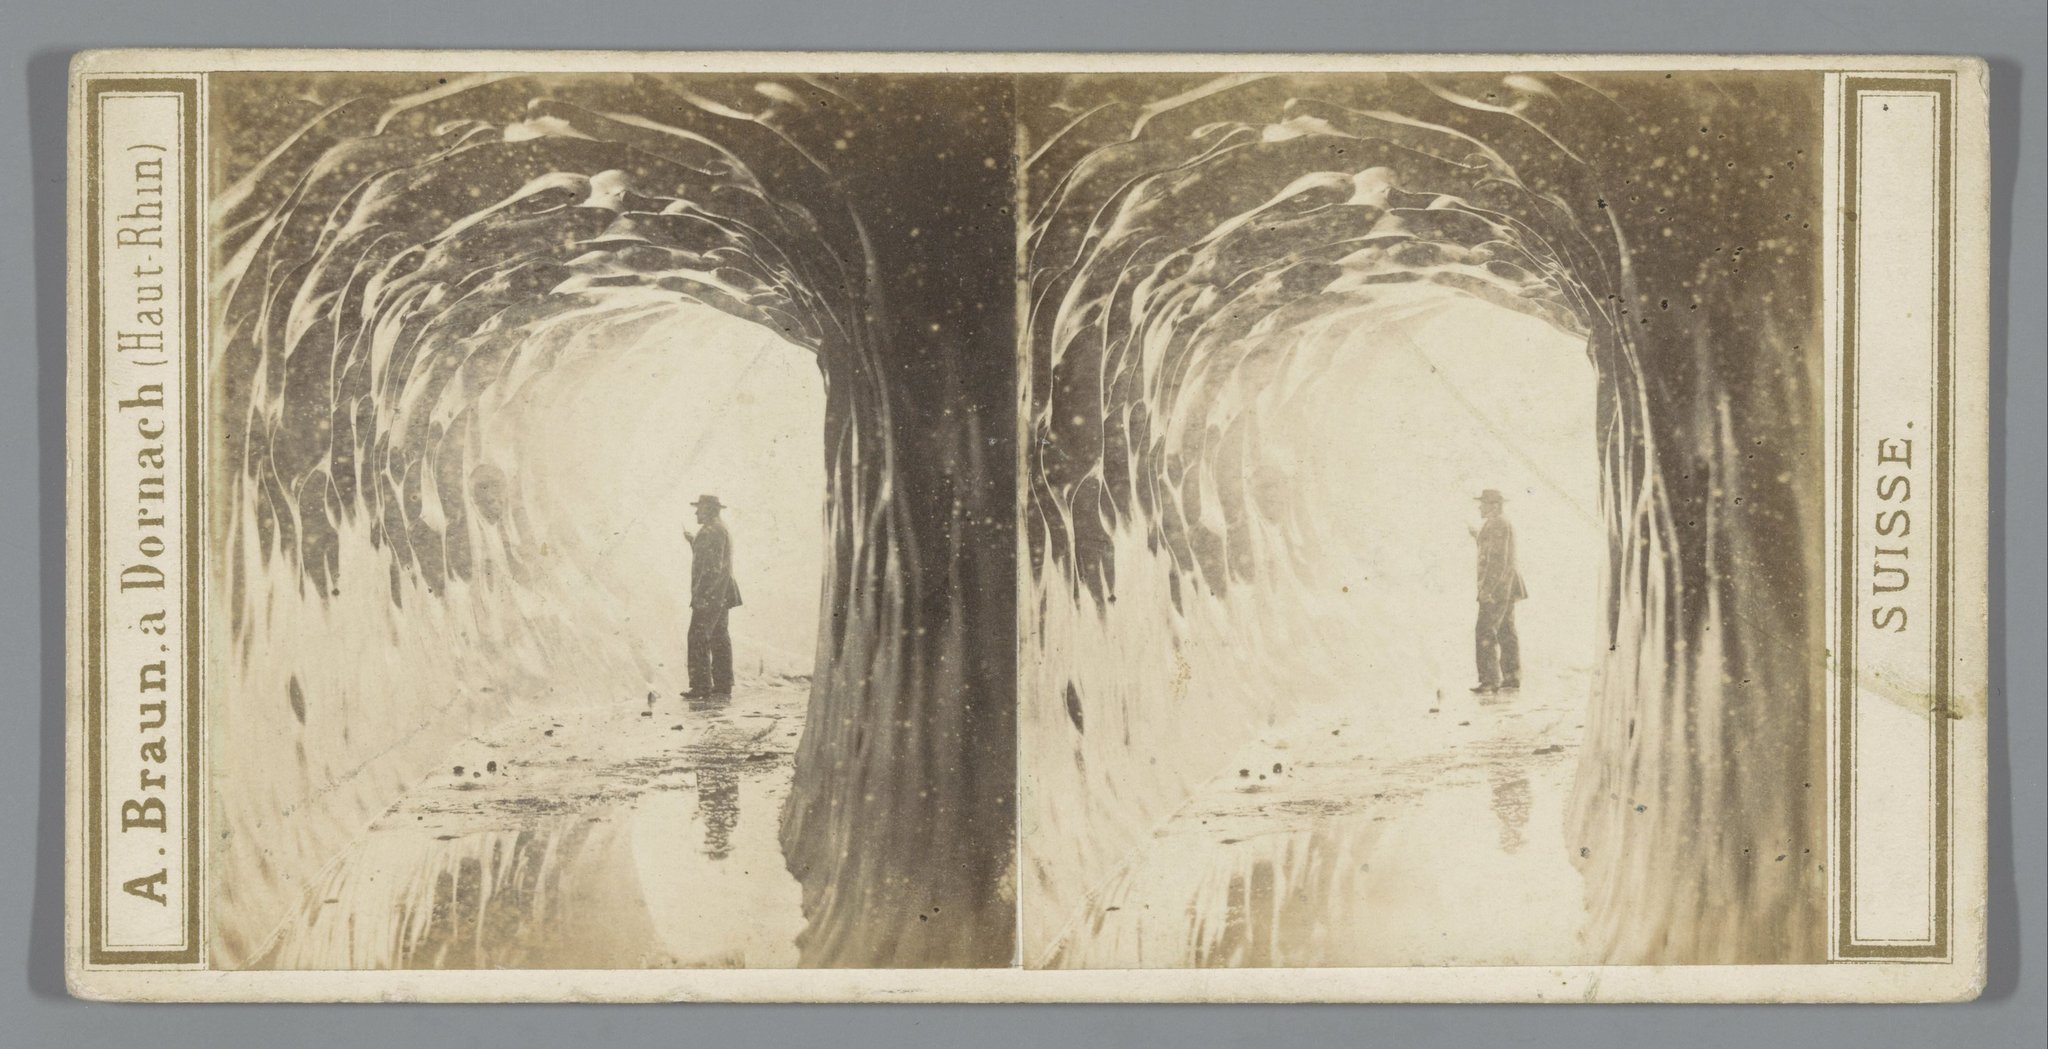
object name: stereograph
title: Grotte artificielle au glacier de Grindelwald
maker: Anonymous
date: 1860-1866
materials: cardboard, paper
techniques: albumen print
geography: dornach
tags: adult man, cave, grotto, glacier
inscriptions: number: ‘No 1810’, inscription: ‘P. Dyserint [?]’